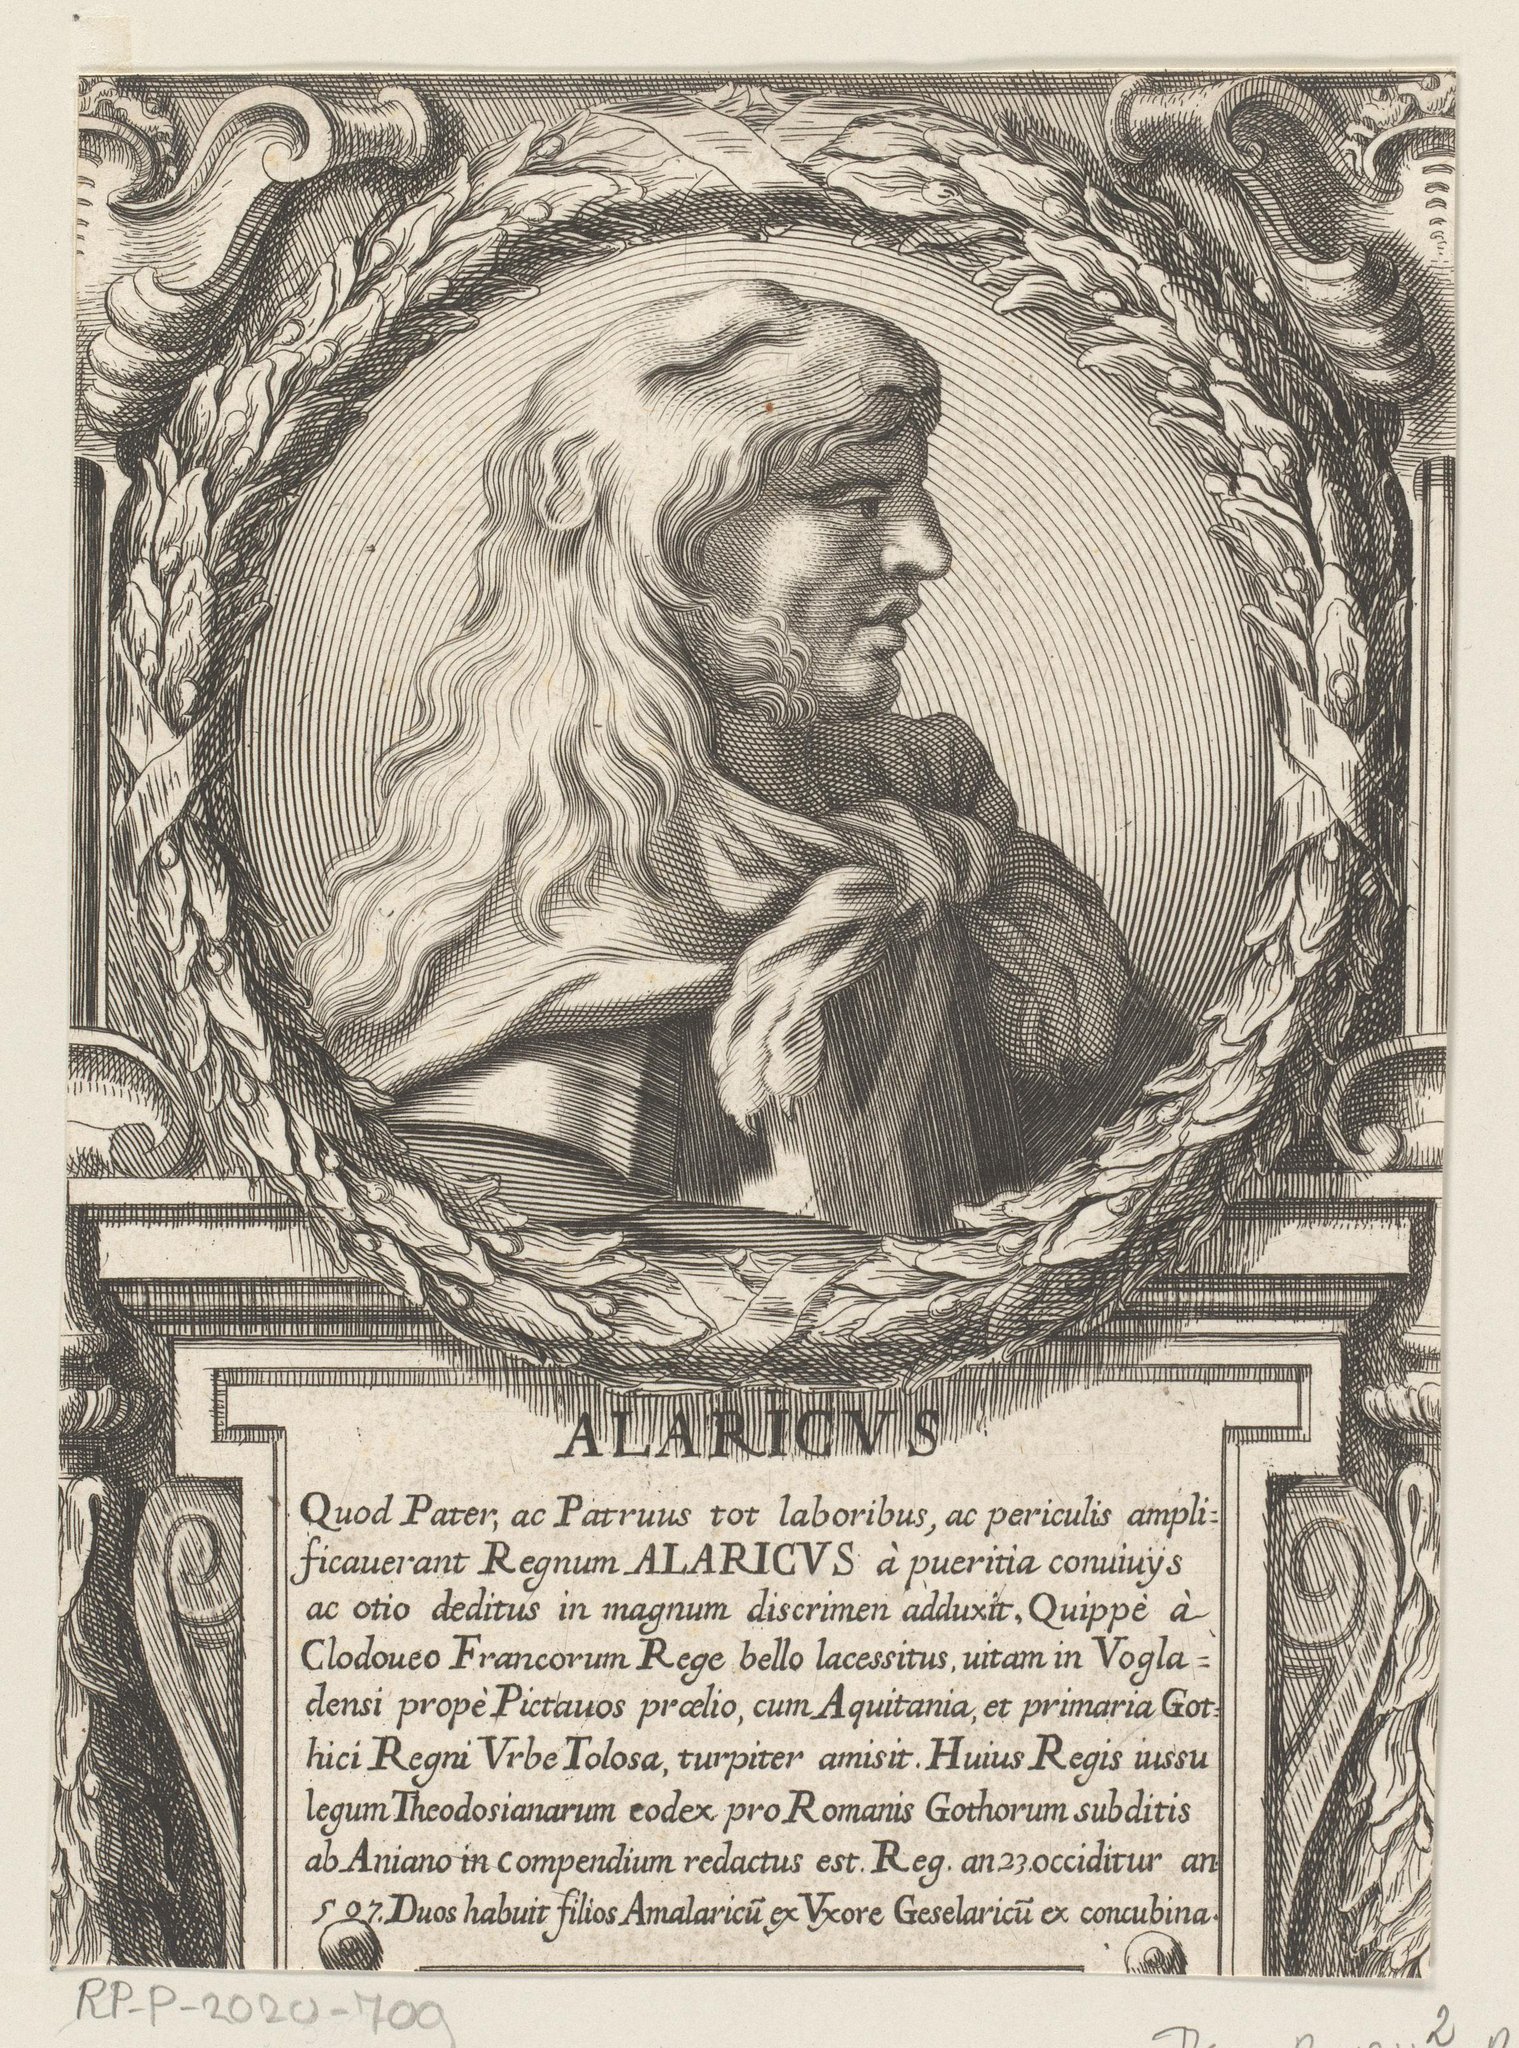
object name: print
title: Alaricus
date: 1685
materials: paper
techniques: engraving, etching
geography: rome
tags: cosenza, historical persons, ruler, sovereign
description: Portret afkomstig van een grote prent, getiteld 'Series Chronologica et Imagines Regu Hispaniae ab Ataulpho ad Carolum II', bestaande uit tien bladen die samengevoegd konden worden, uitgegeven door Giovanni Giacomo de' Rossi in 1685.